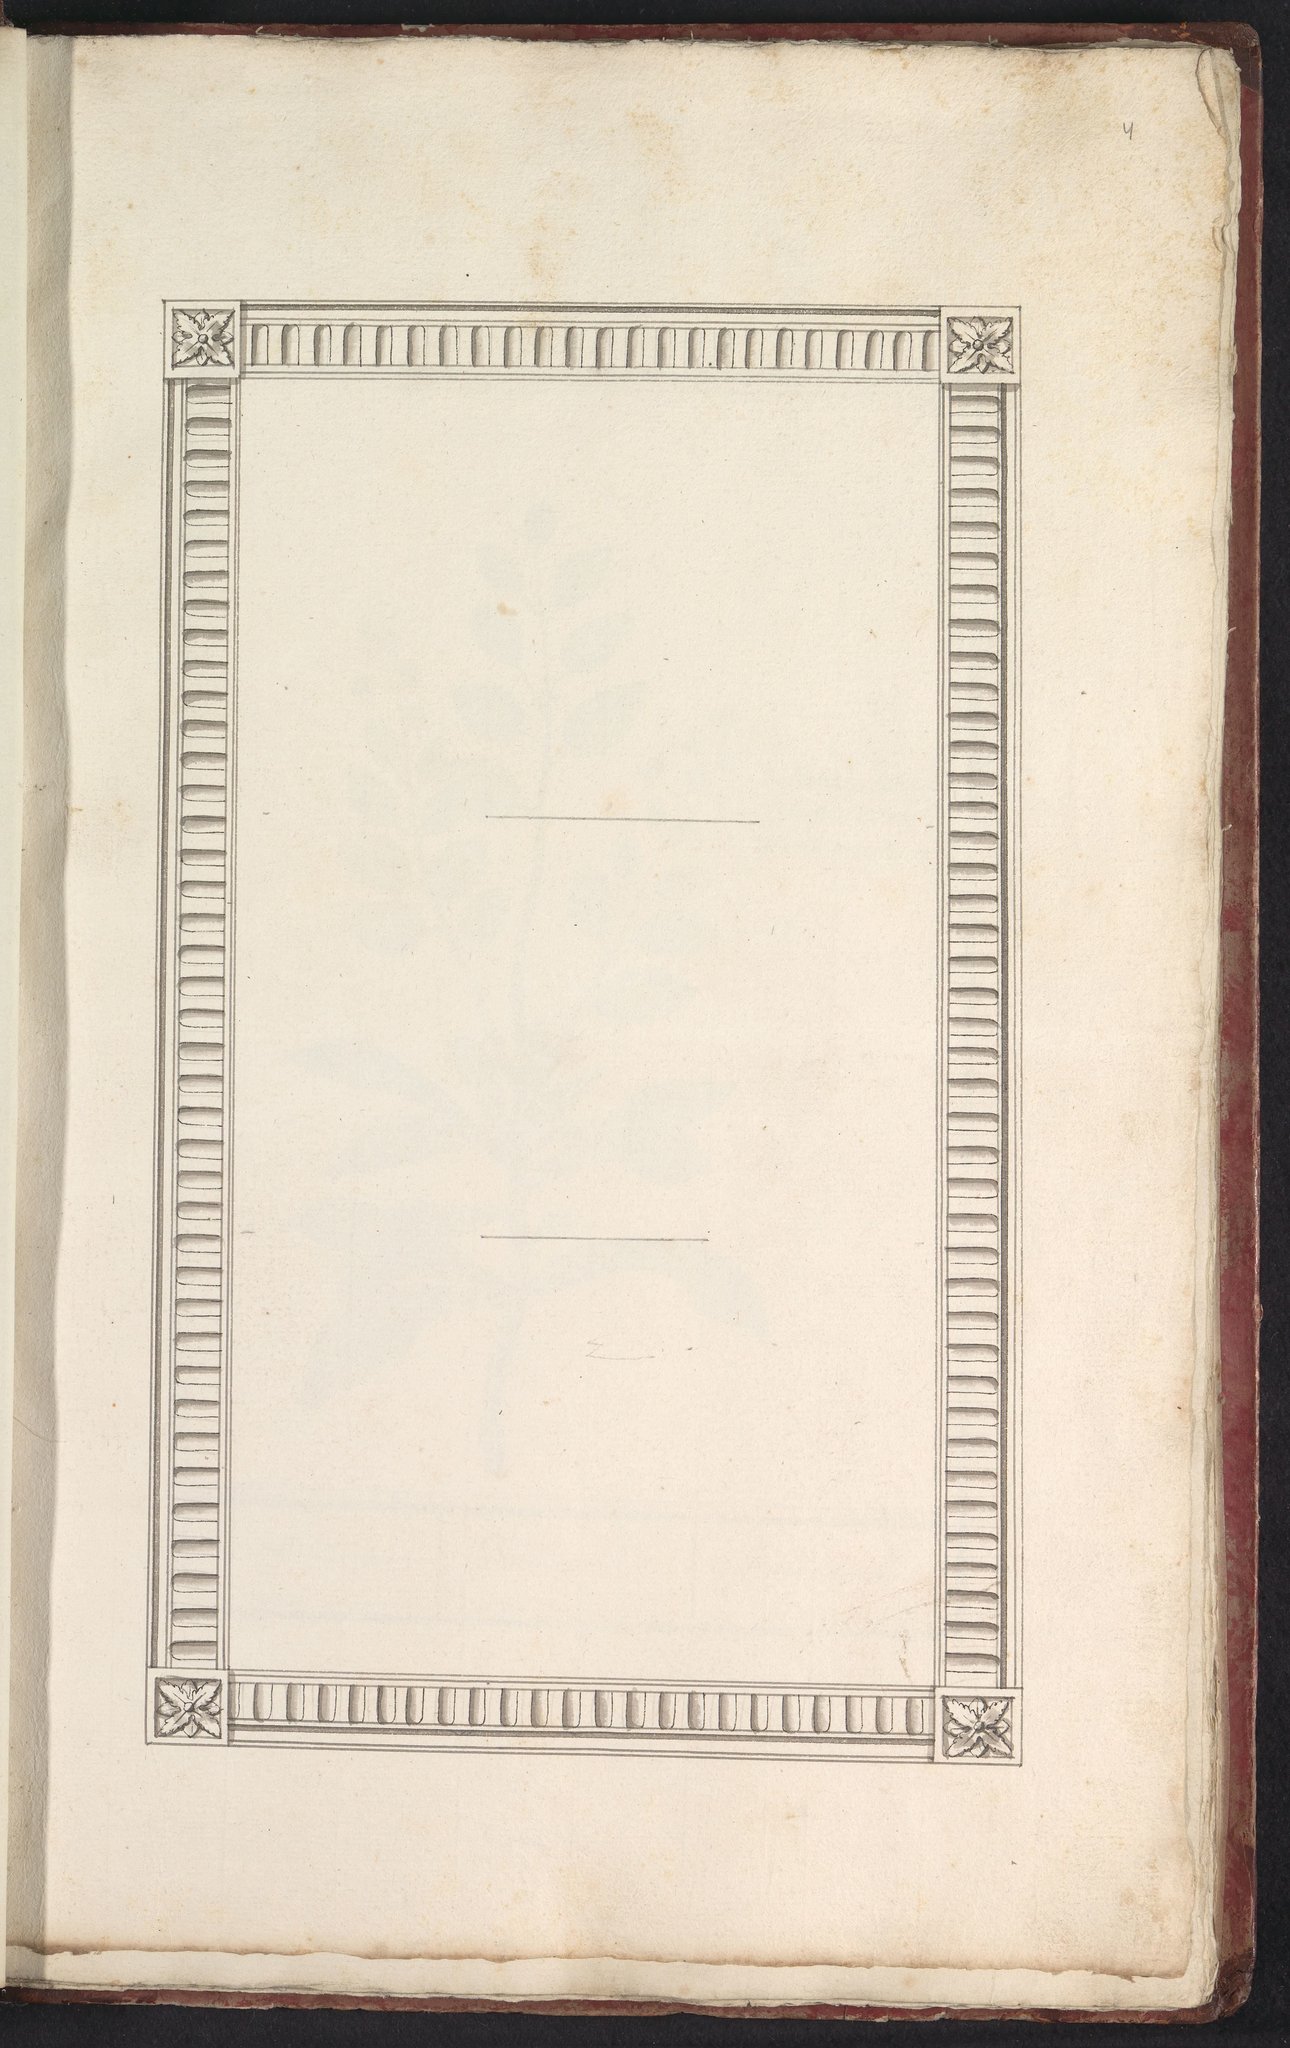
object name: drawing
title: Omlijsting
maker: Anonymous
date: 1809-1814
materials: paper, pencil, watercolor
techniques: brush, pen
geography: southern netherlands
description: Lege omlijsting. Onderdeel van het vierde album met tekeningen van bloemen en paddestoelen. Elfde van twaalf albums met tekeningen van dieren, vogels en planten bekend rond 1600, gemaakt in opdracht van keizer Rudolf II. Met toelichting in Nederlands, Latijn en Frans.